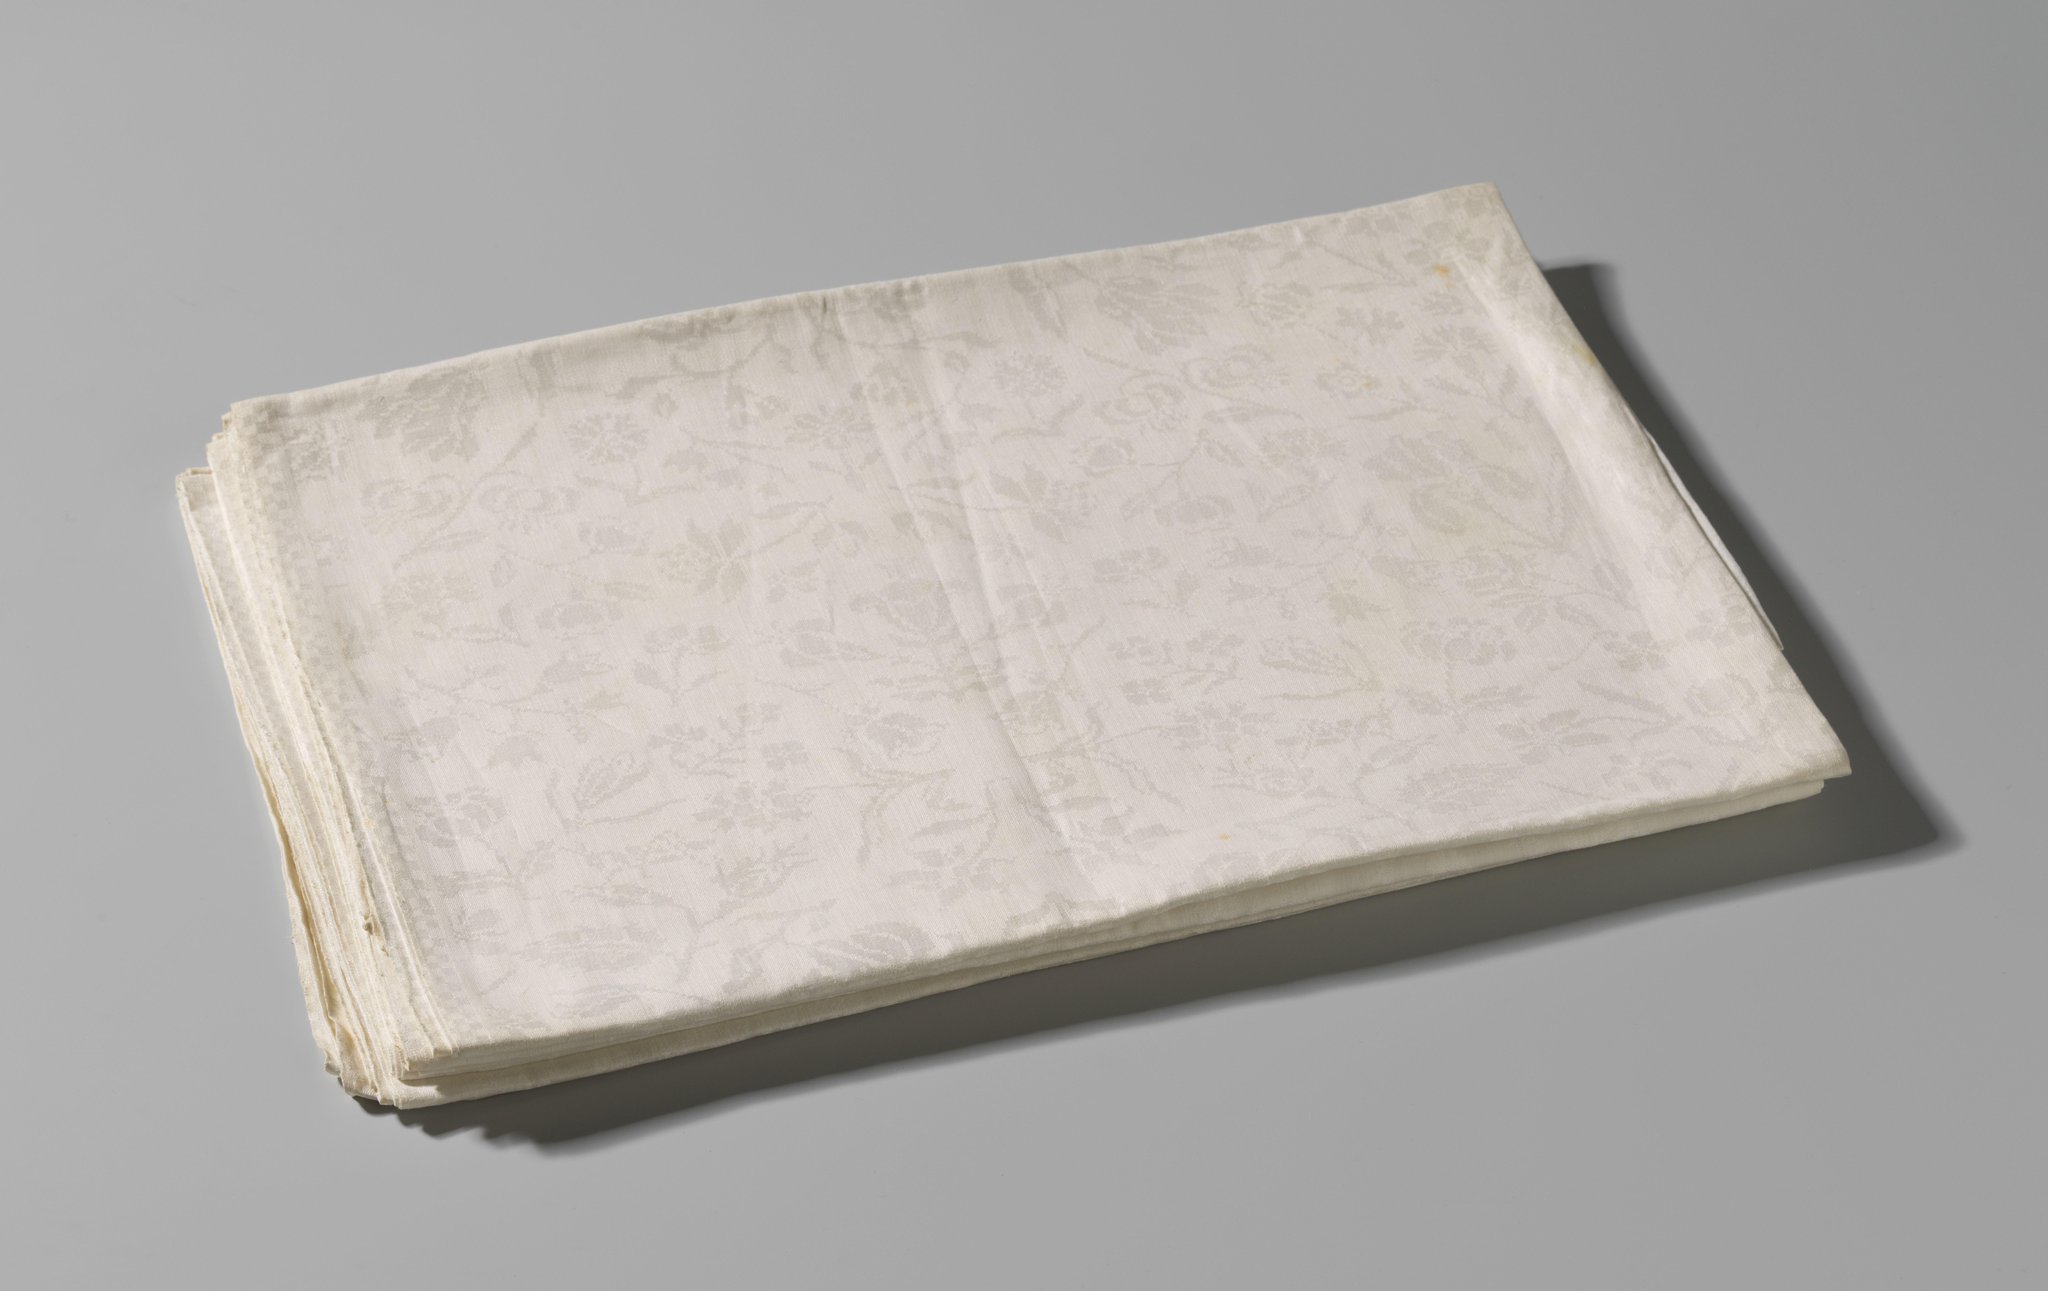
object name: tablecloth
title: Tafellaken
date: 1677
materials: linen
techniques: damask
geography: flanders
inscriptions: date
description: Wit linnen damasten tafellaken met gestrooide bloemen, waaronder keizerskroon, slak, vlinders en andere insecten.